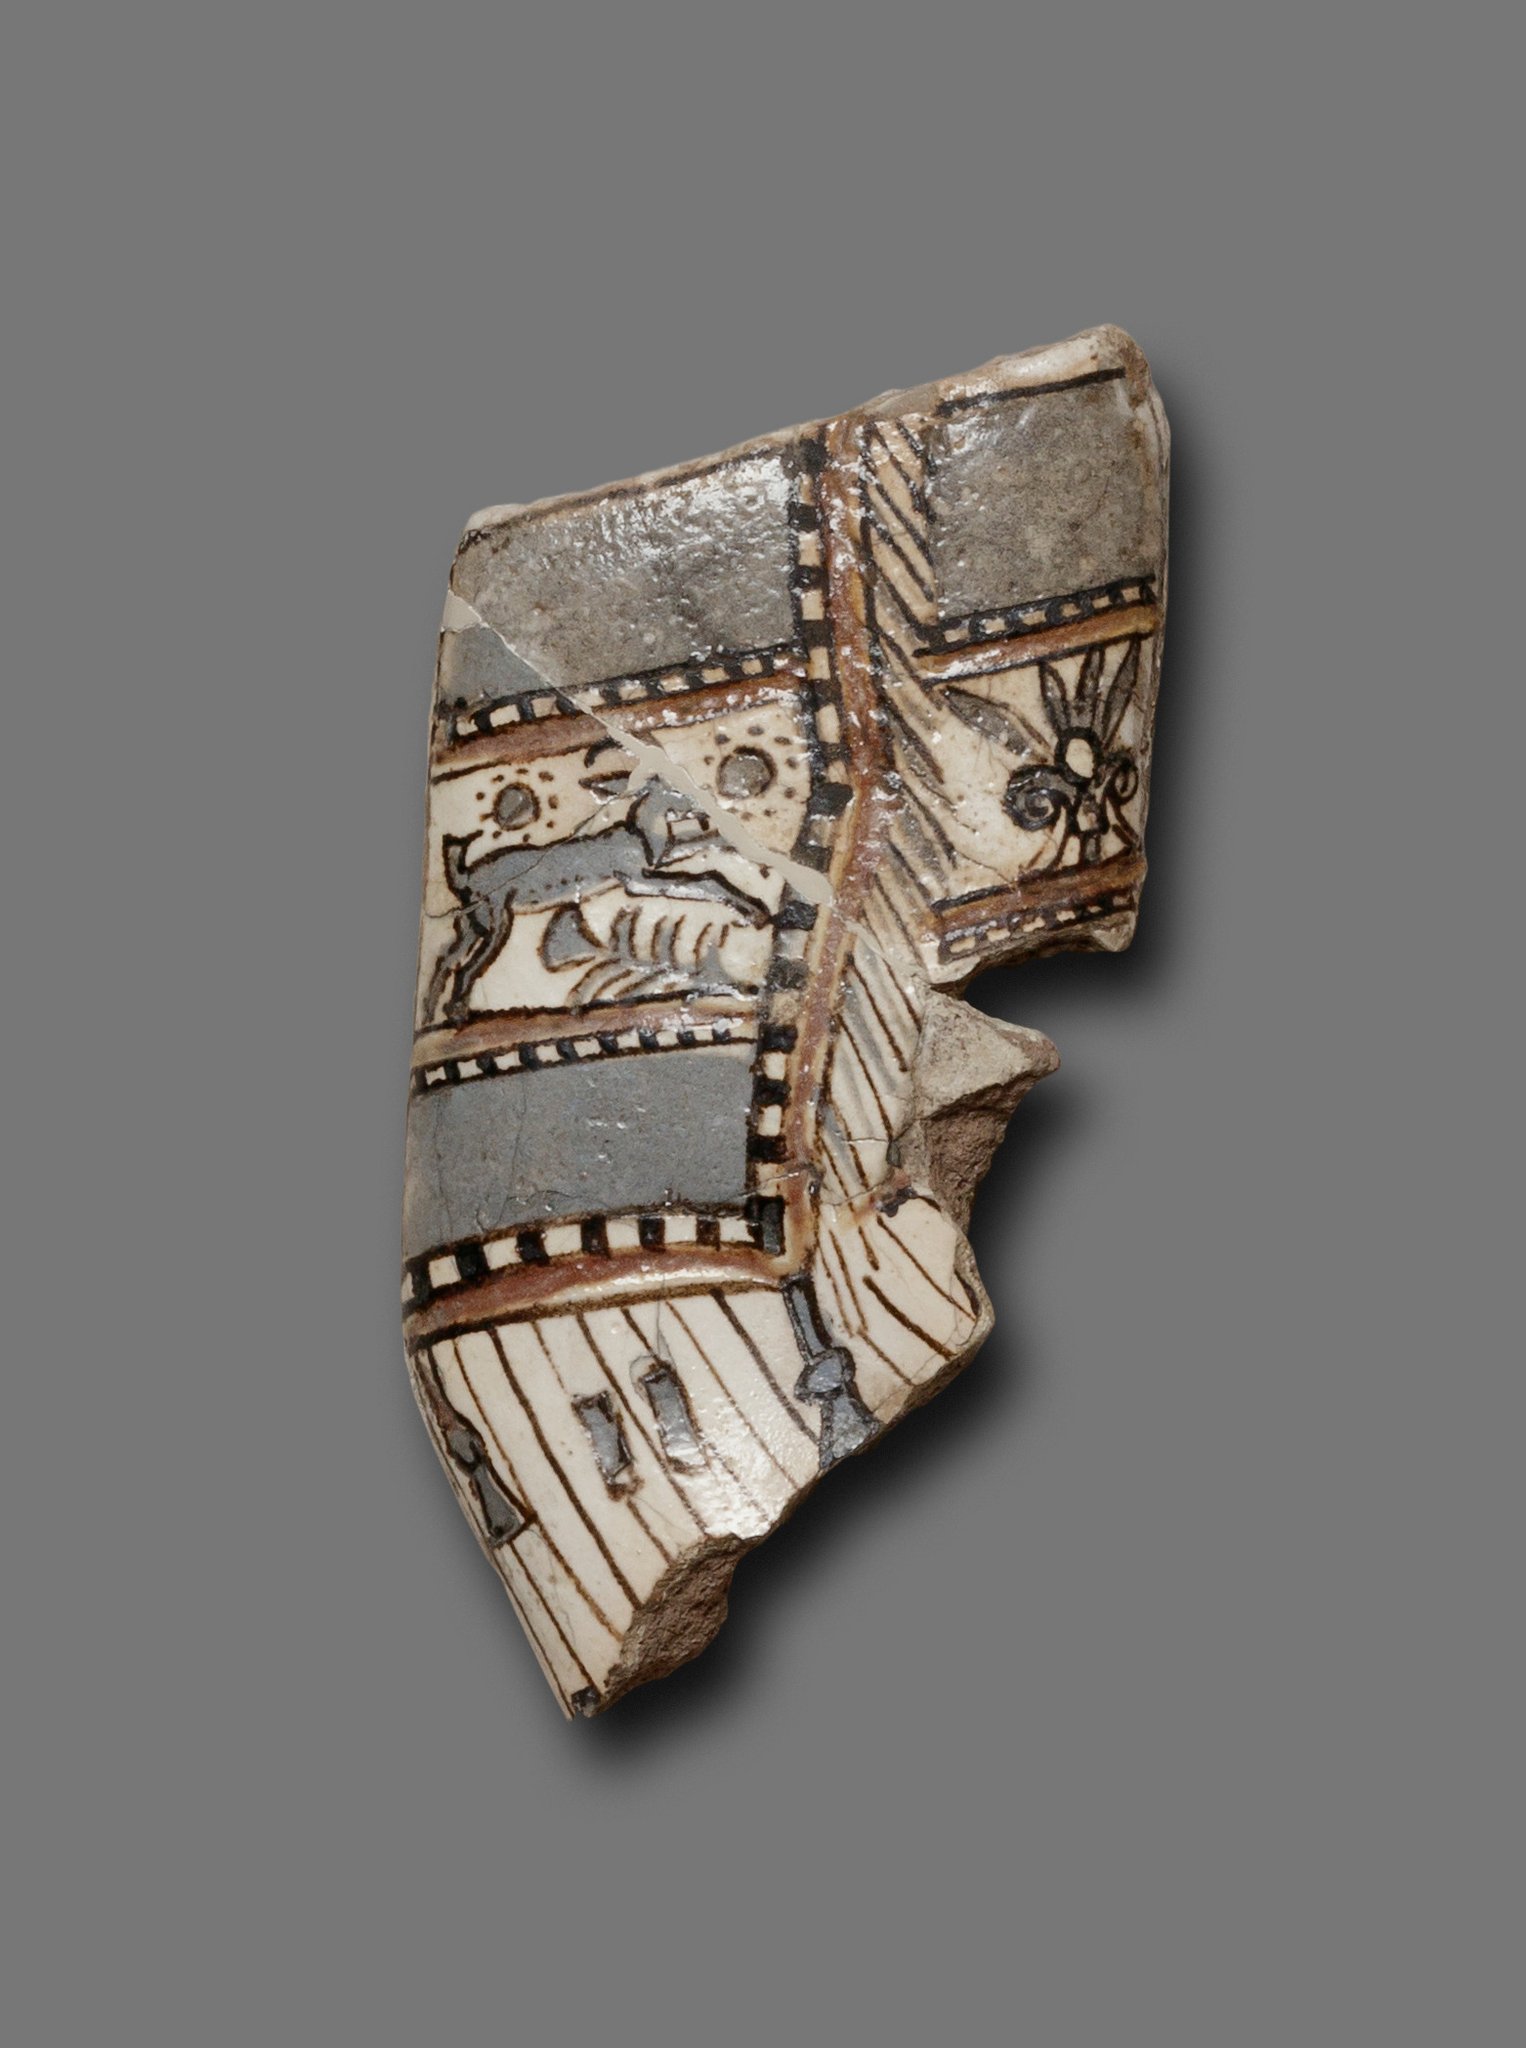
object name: tile inlay, palace of ramesses ii, foreigner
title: Tile Inlay from the Palace of Ramesses II, Captives of Non-Semitic Northern Peoples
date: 1279-1213 BCE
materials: faience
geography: egypt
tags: animals